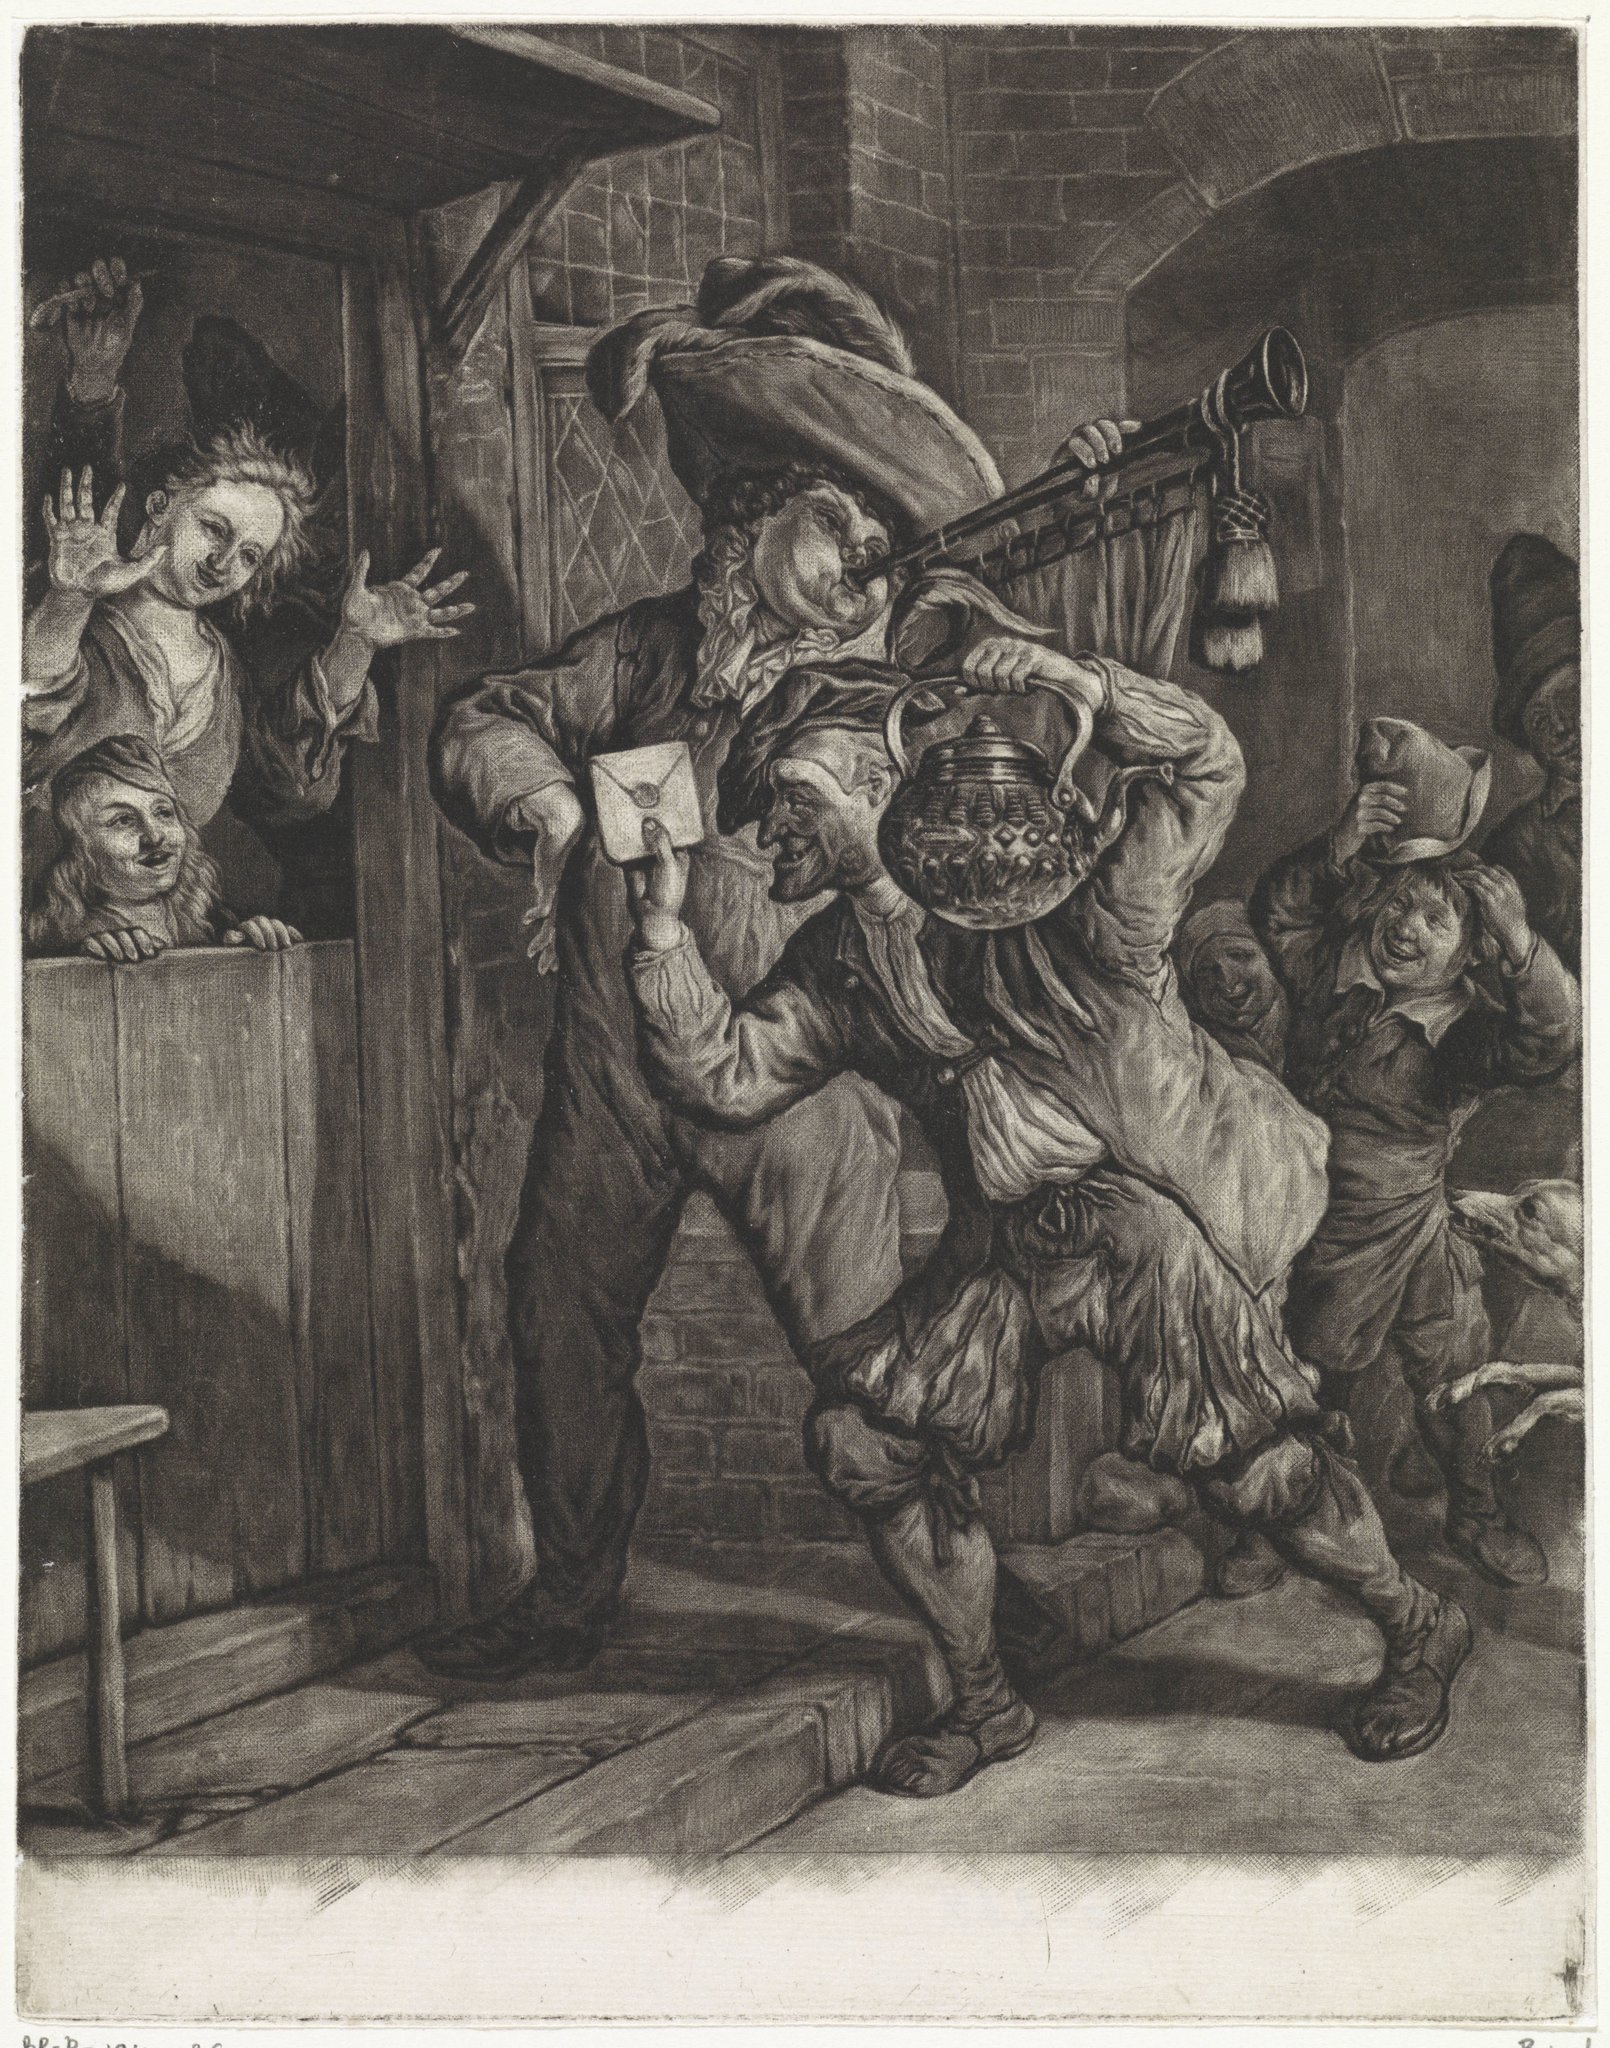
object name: print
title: Loterij van Grootebroek, 1694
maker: cornelis dusart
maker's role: draughtsman, painter, print maker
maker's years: 1660-1704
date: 1694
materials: paper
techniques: mezzotint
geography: northern netherlands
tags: raffle, lottery, lottery booth (on pleasure fair)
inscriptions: collector's mark: Lugt 2228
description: De loterij gehouden voor de slachtoffers van de grote brand in het dorp Grootebroek (bij Enkhuizen) op 20 augustus 1694. Een man bezorgt een ketel en een verzegelde brief bij de prijswinnaars van de loterij.